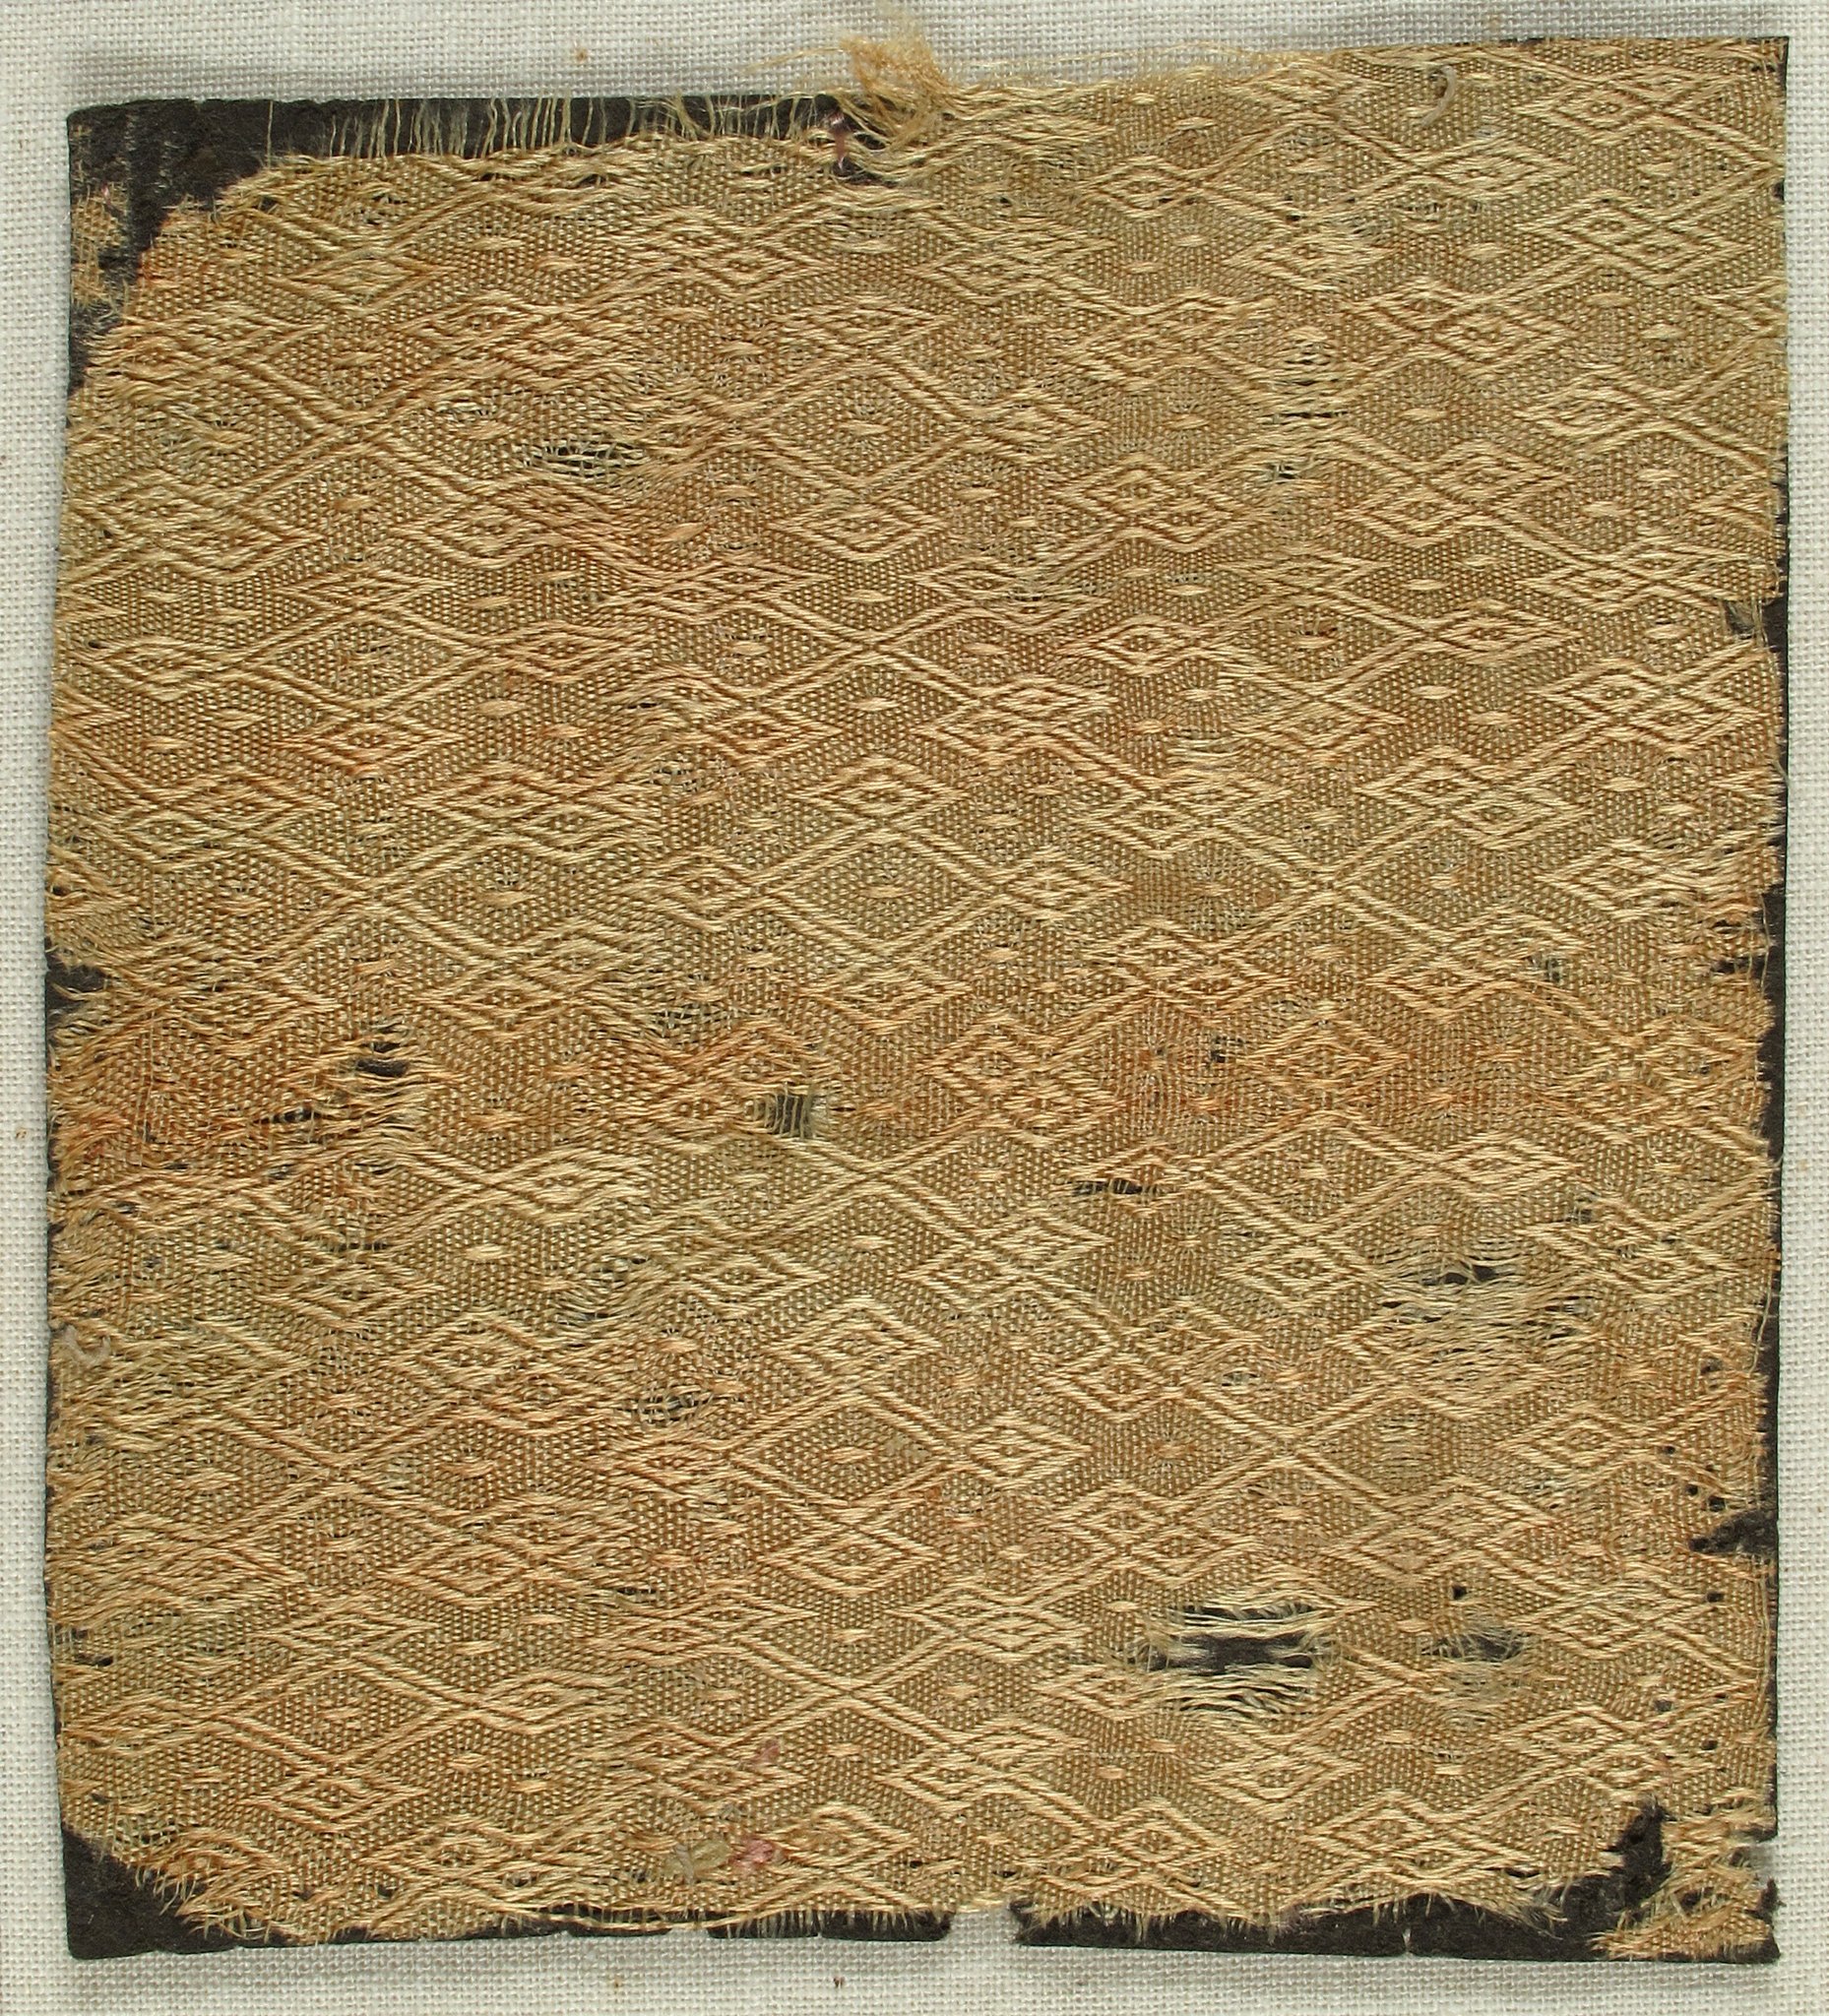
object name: textile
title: Textile with Figured Silk Weave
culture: german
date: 1401-1500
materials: silk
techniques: weave